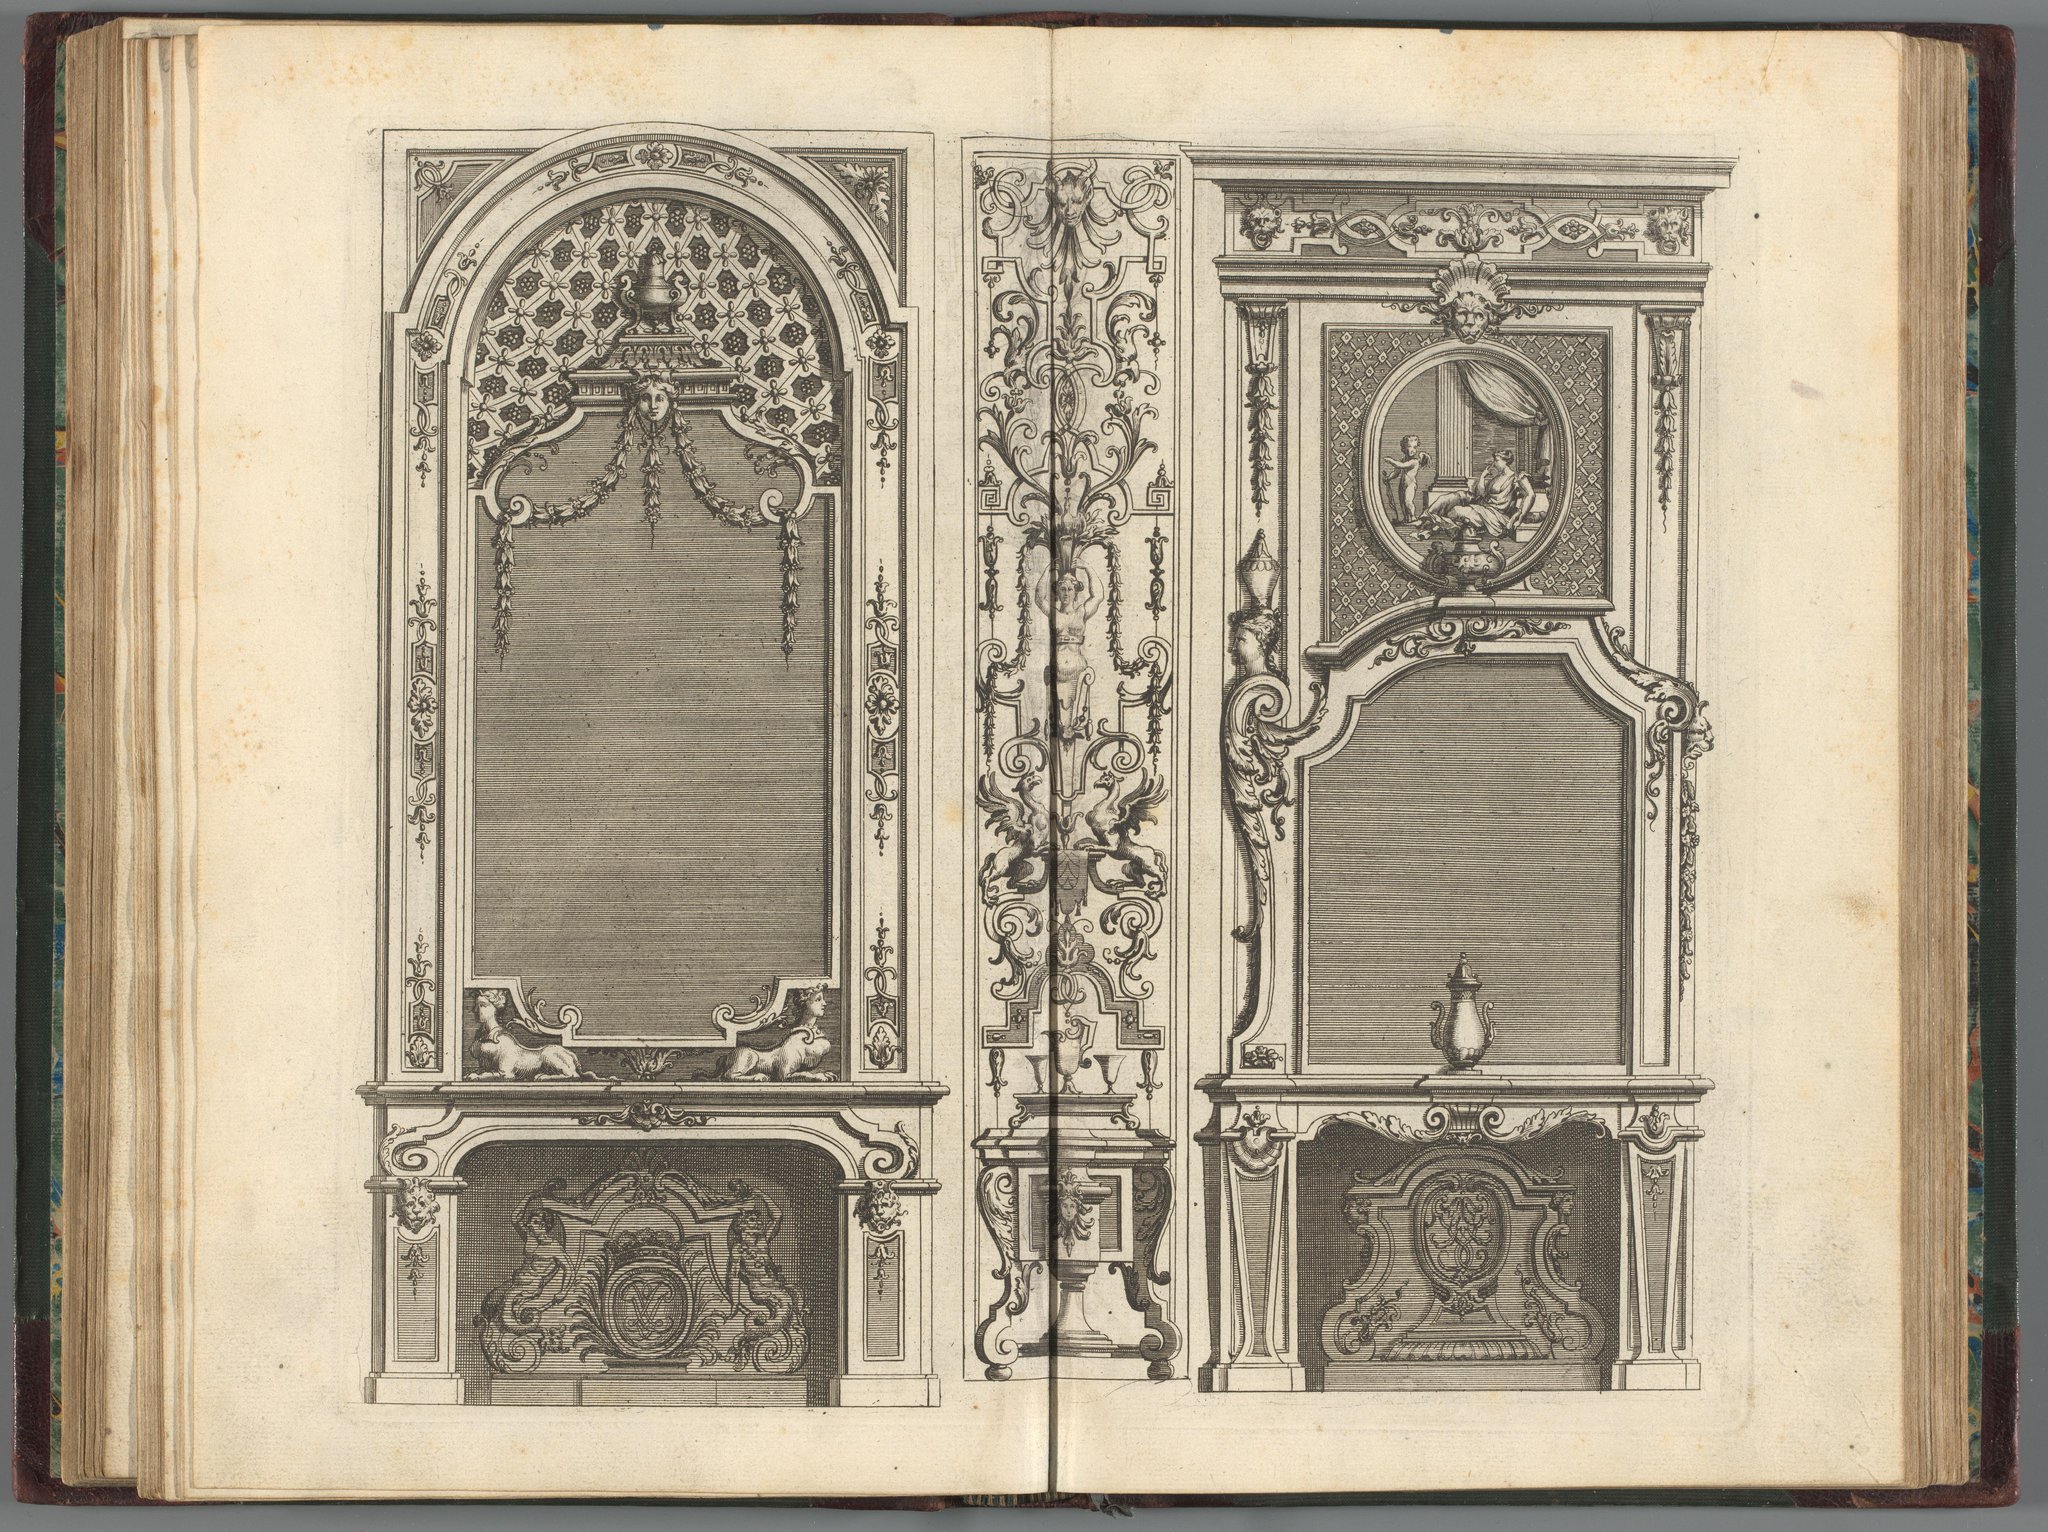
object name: ornament print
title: Haarden met sfinxen en medaillon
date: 1686-1724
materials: paper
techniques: etching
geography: augsburg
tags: ornaments ~ art, fire-screen, sphinx (lion/woman); 'sfinge' (ripa), ornament ~ medallion, open hearth, fire-place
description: Twee geornamenteerde haarden. Links met een vaas, een maskers, guirlandes, twee sfinxen en een haardplaat met meermannen. Rechts met een medaillon met Venus en Amor, een kariatide, een vaas en een haardplaat. De haarden flankeren een paneel met vlechtwerk, een kariatide en een tafel met vaatwerk. Prent maakt deel uit van een album. Hoogstwaarschijnlijk gespiegelde kopie naar Frans origineel.